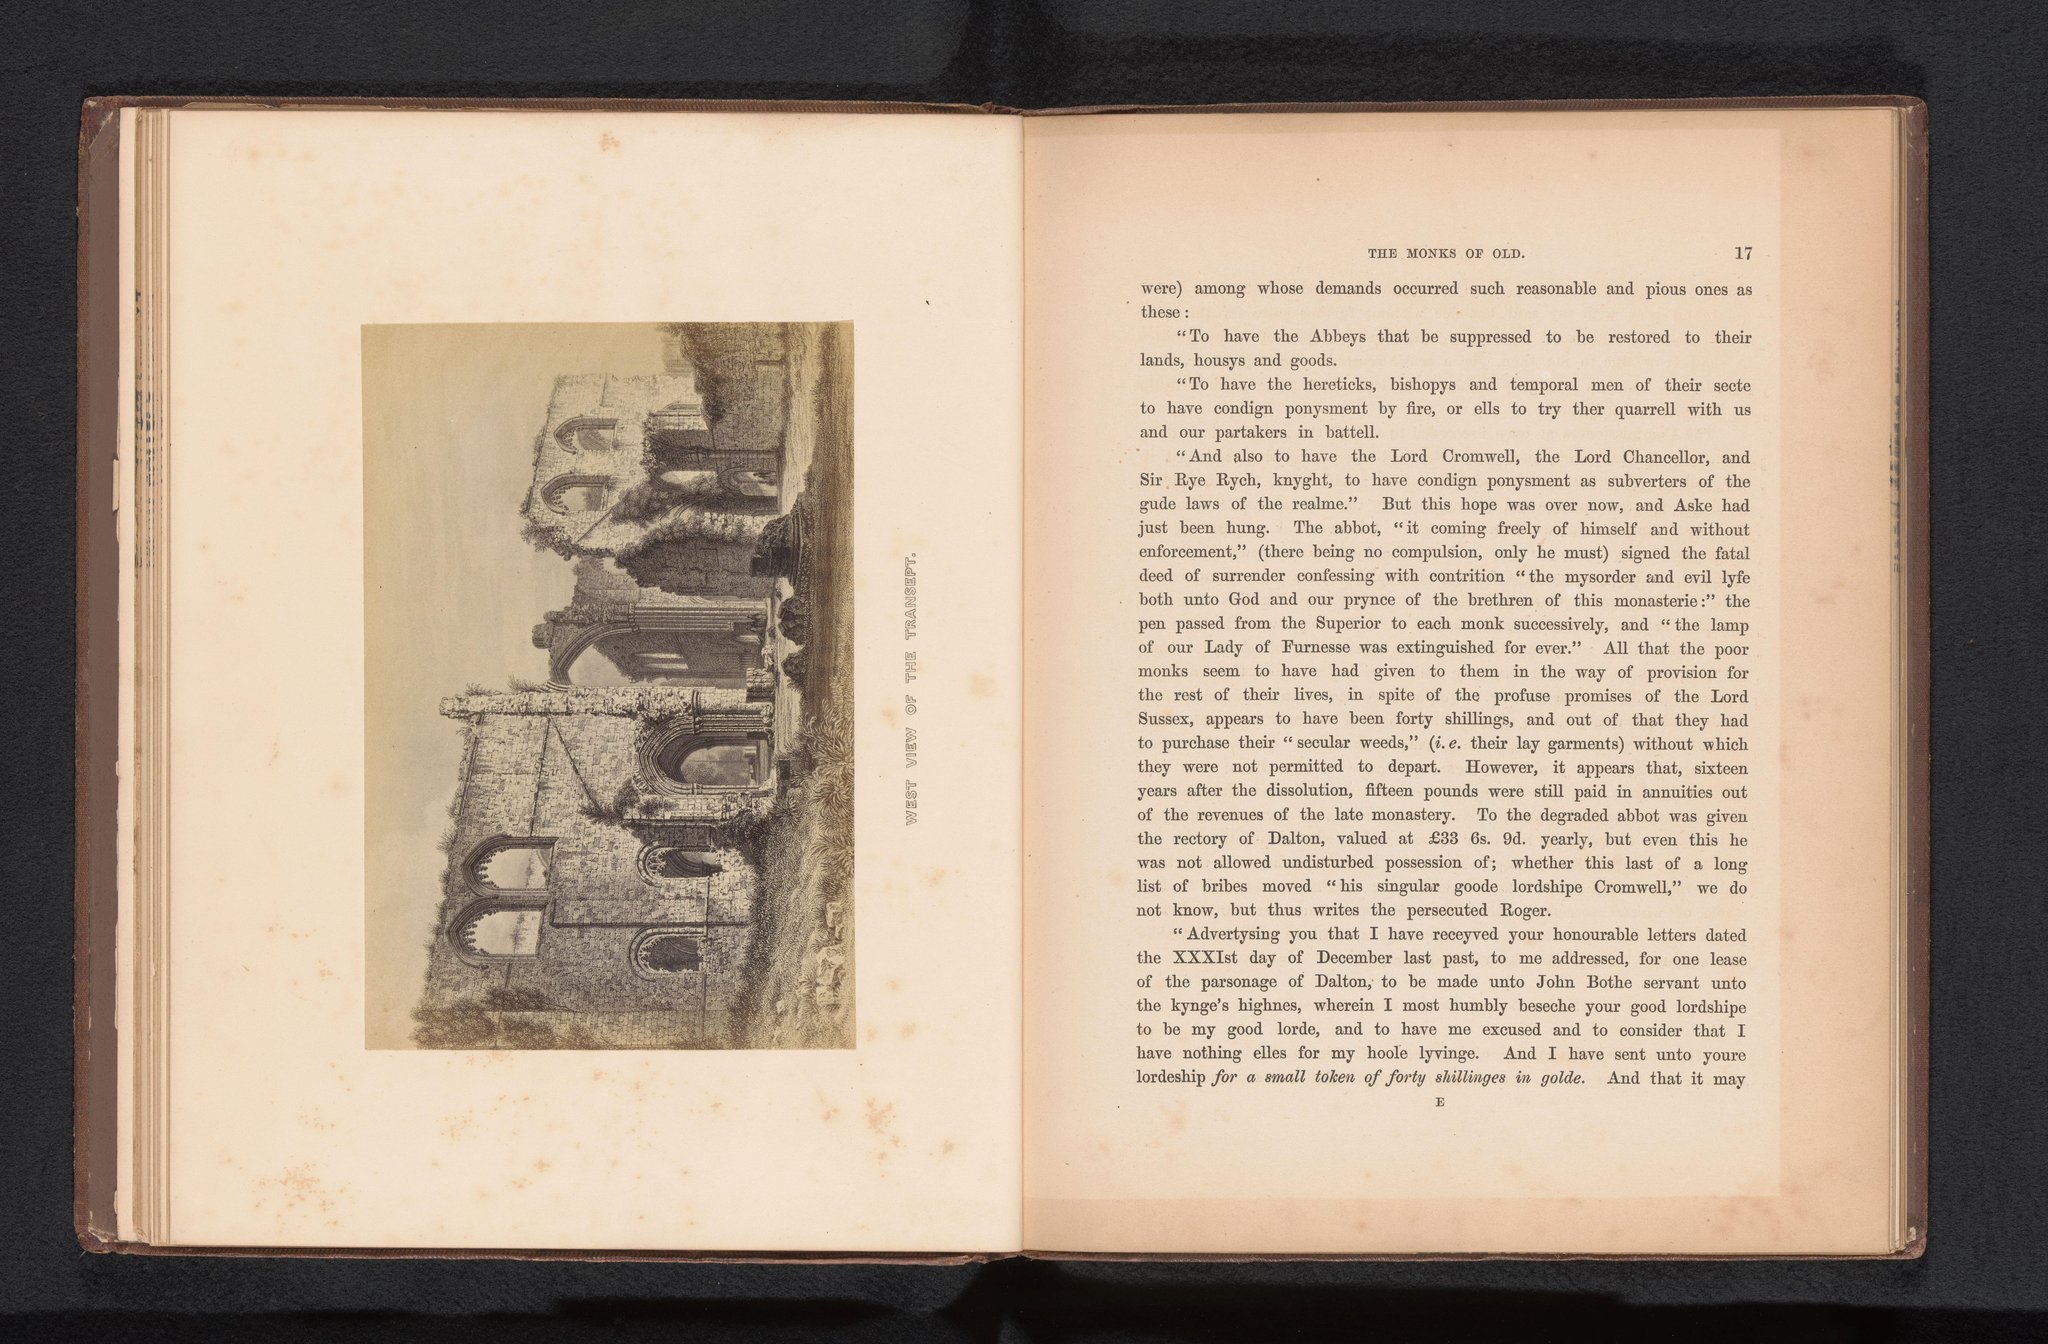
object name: reproduction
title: West view of the transept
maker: Anonymous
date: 1859-1864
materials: photographic support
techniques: albumen print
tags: parts of church exterior and annexes: portal